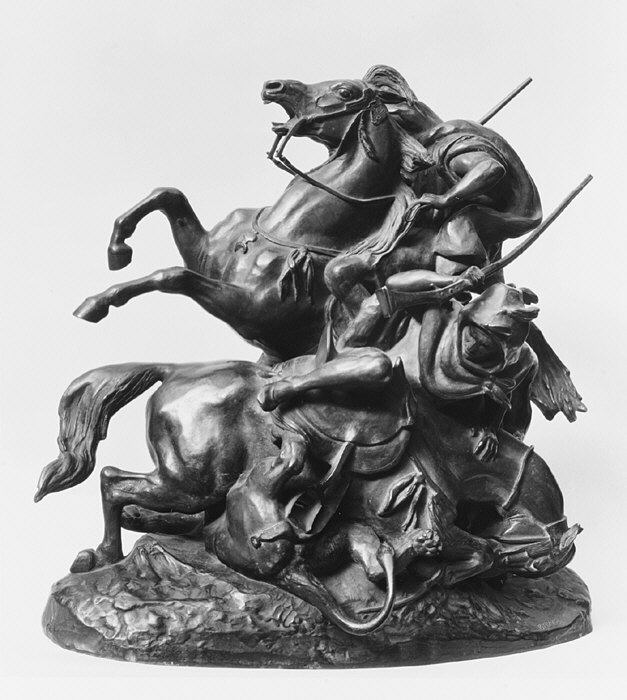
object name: statuette group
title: Two Mounted Arabs Killling a Lion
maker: antoine-louis barye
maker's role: artist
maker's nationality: french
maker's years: 1795-1875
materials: bronze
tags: men,hunting,horses,lions